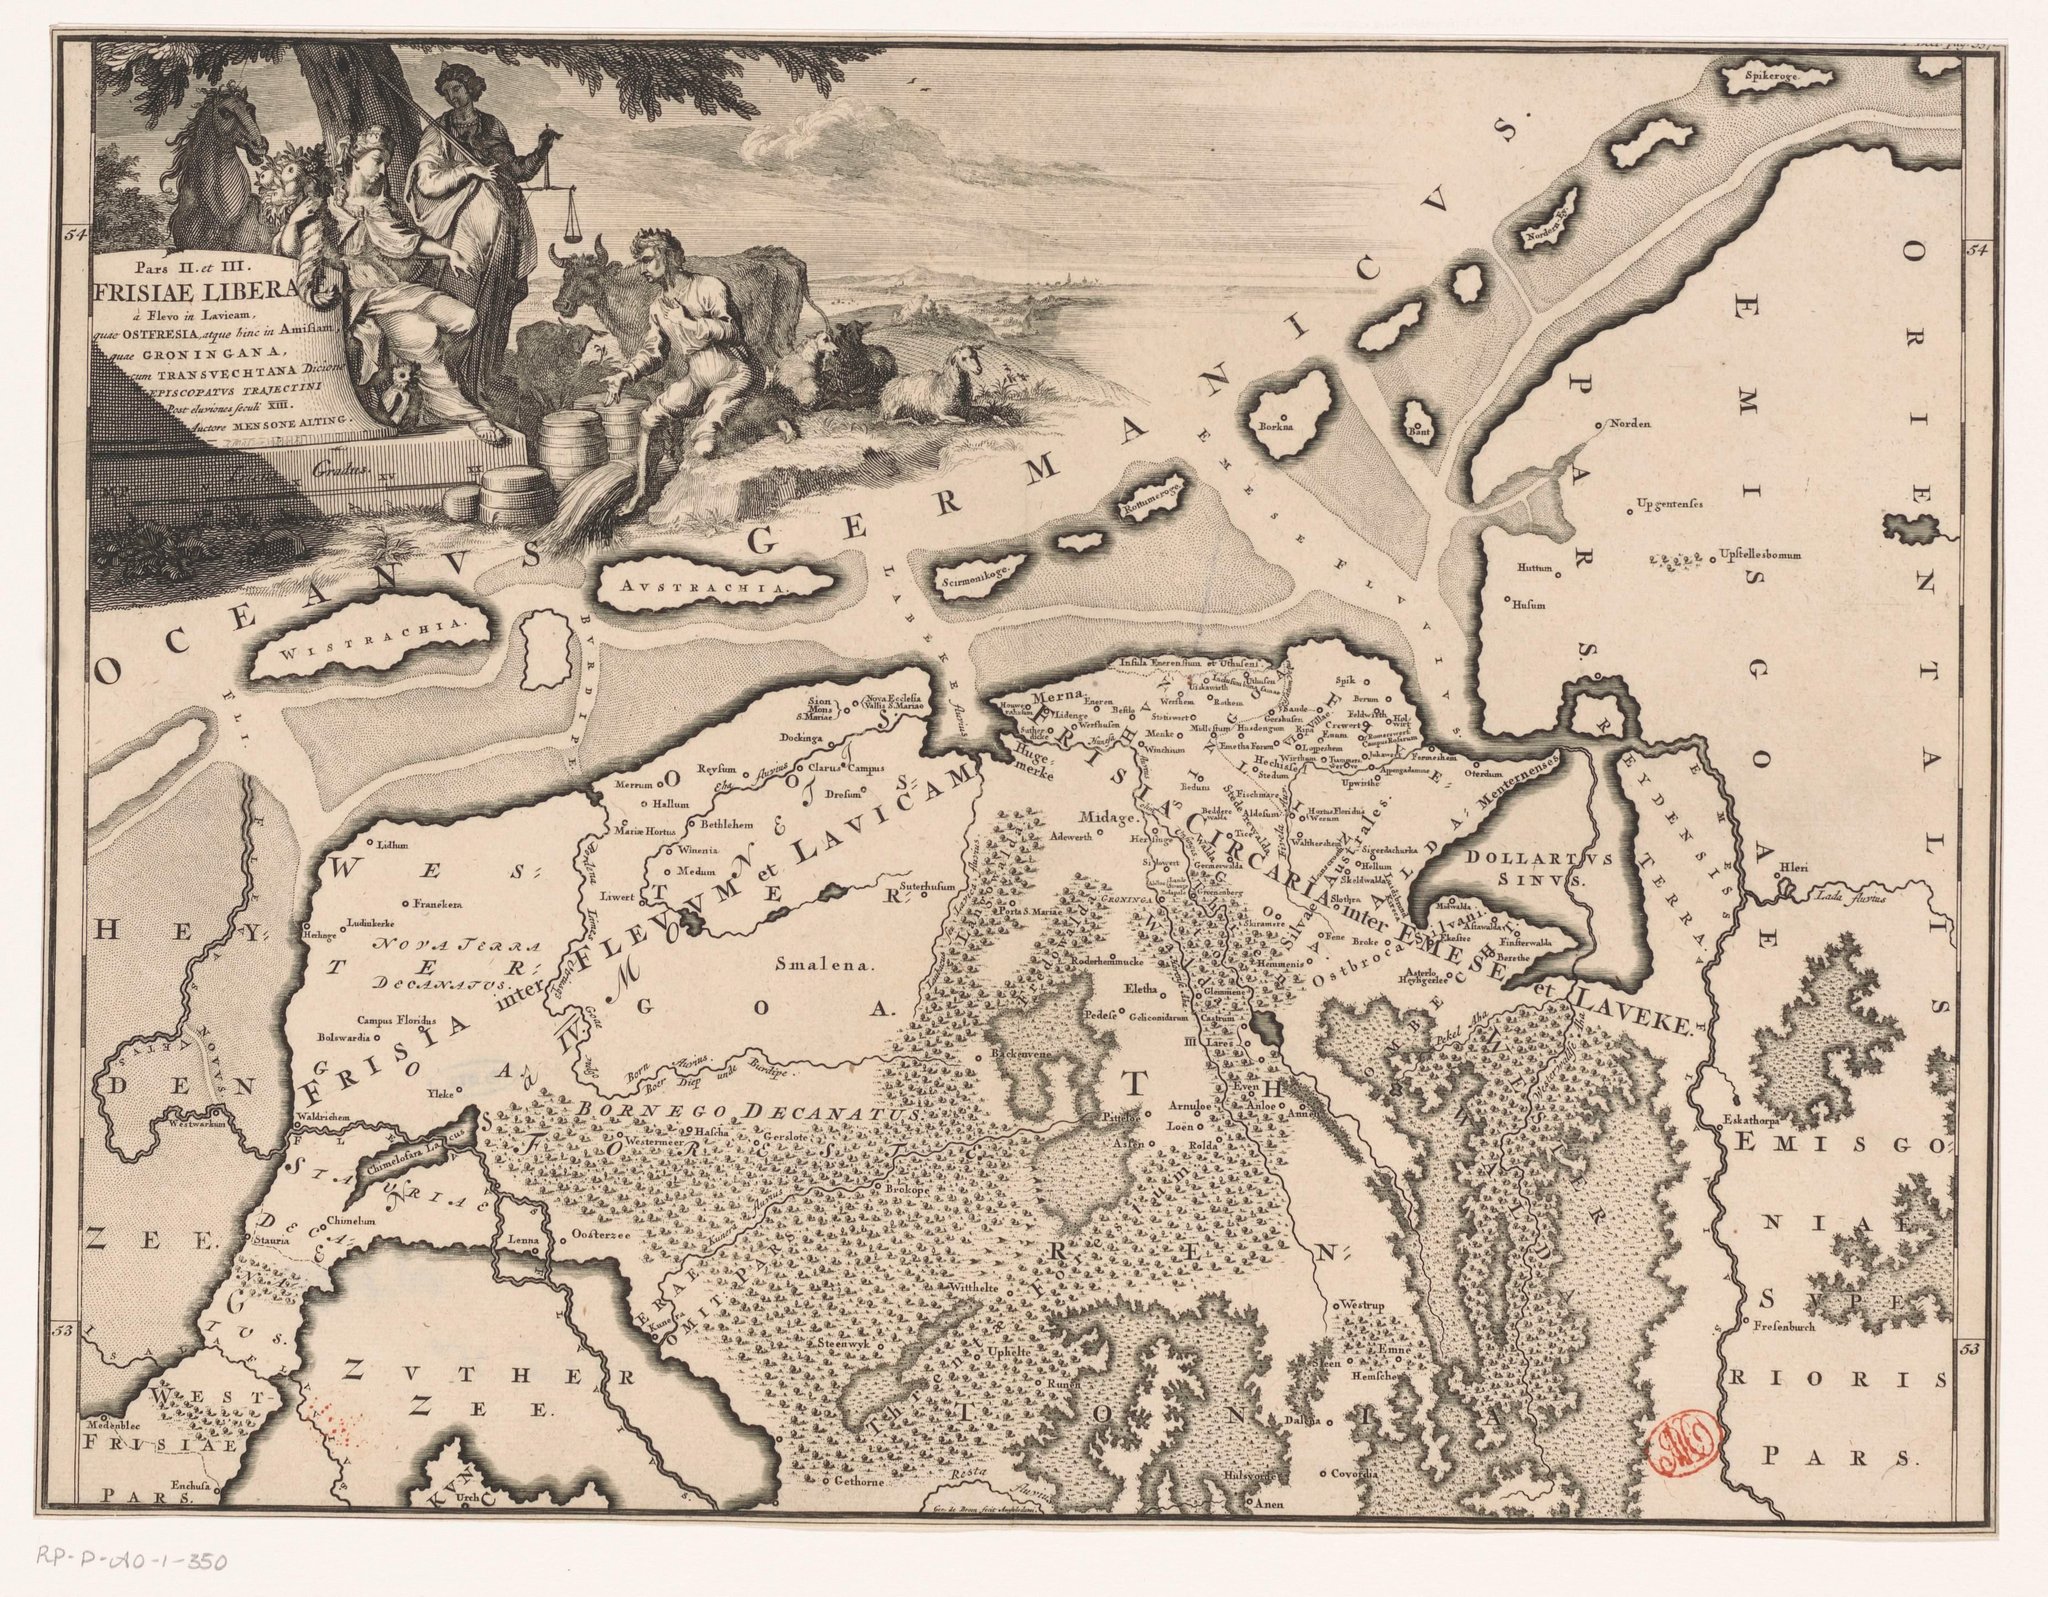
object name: history print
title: Historische kaart van Nederland met de gebieden van de Bataven en Friezen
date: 1697-1700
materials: paper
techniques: engraving, etching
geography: amsterdam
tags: maps of separate countries or regions, concordia as roman personification, justitia (justice) as roman personification, netherlands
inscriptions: collector's mark: Lugt 2228, collector's mark: Lugt 195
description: Maakt deel uit van 16 kaarten van het land van de Bataven en de Friezen eerst vervaardigd voor en opgenomen in Alting, Menso. Descriptio, secundum antiquos, agri Batavi & Frisii. 2 delen. Amsterdam: Henricus Wetstein, 1697-1700. Hergebruikt in Halma, François. Tooneel der Vereenigde Nederlanden, en onderhorige landschappen (...). 2 delen. Leeuwarden: Hendrik Halma, 1725. Deze kaart is gebruikt in Halma's Tooneel der Vereenigde Nederlanden (1725) en is waarschijnlijk te vinden in deel 1, p. 337.